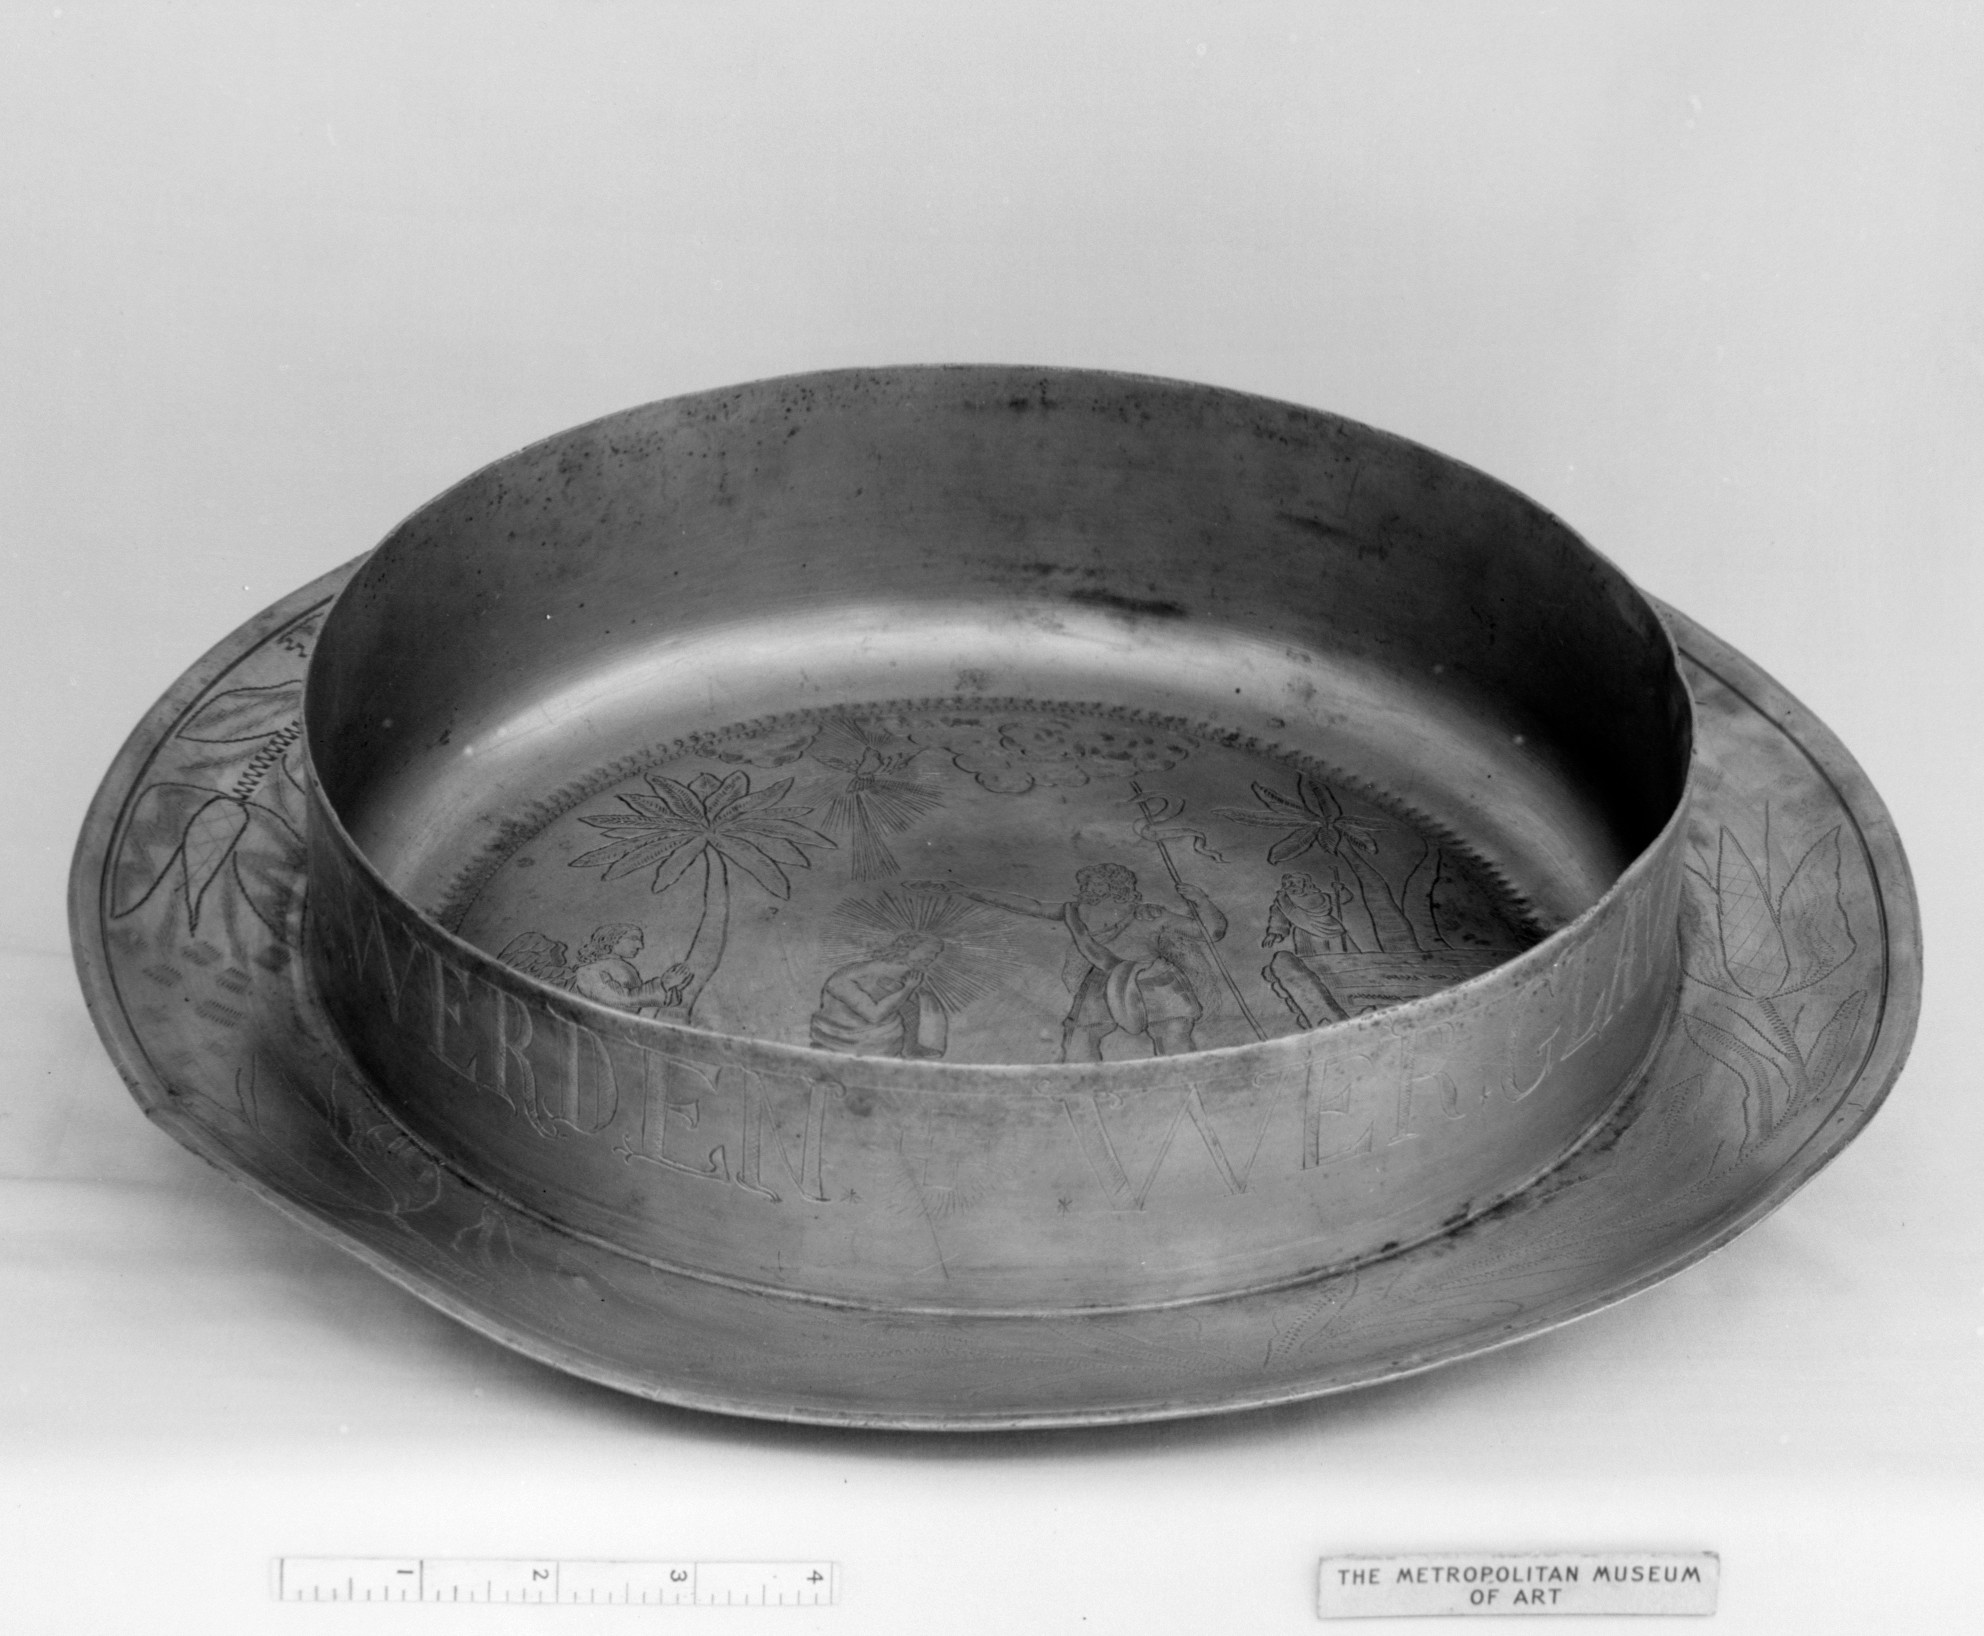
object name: baptismal basin or font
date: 1501-1600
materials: pewter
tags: baptismal fonts